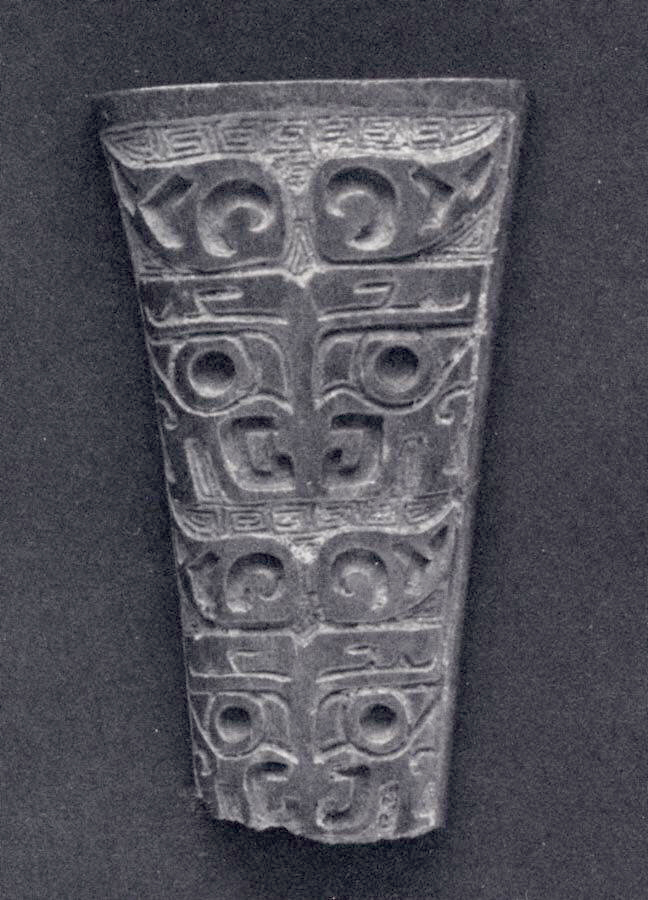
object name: spatula fragment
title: Fragment of a Spatula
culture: chinese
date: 1300-1001 BCE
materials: bone